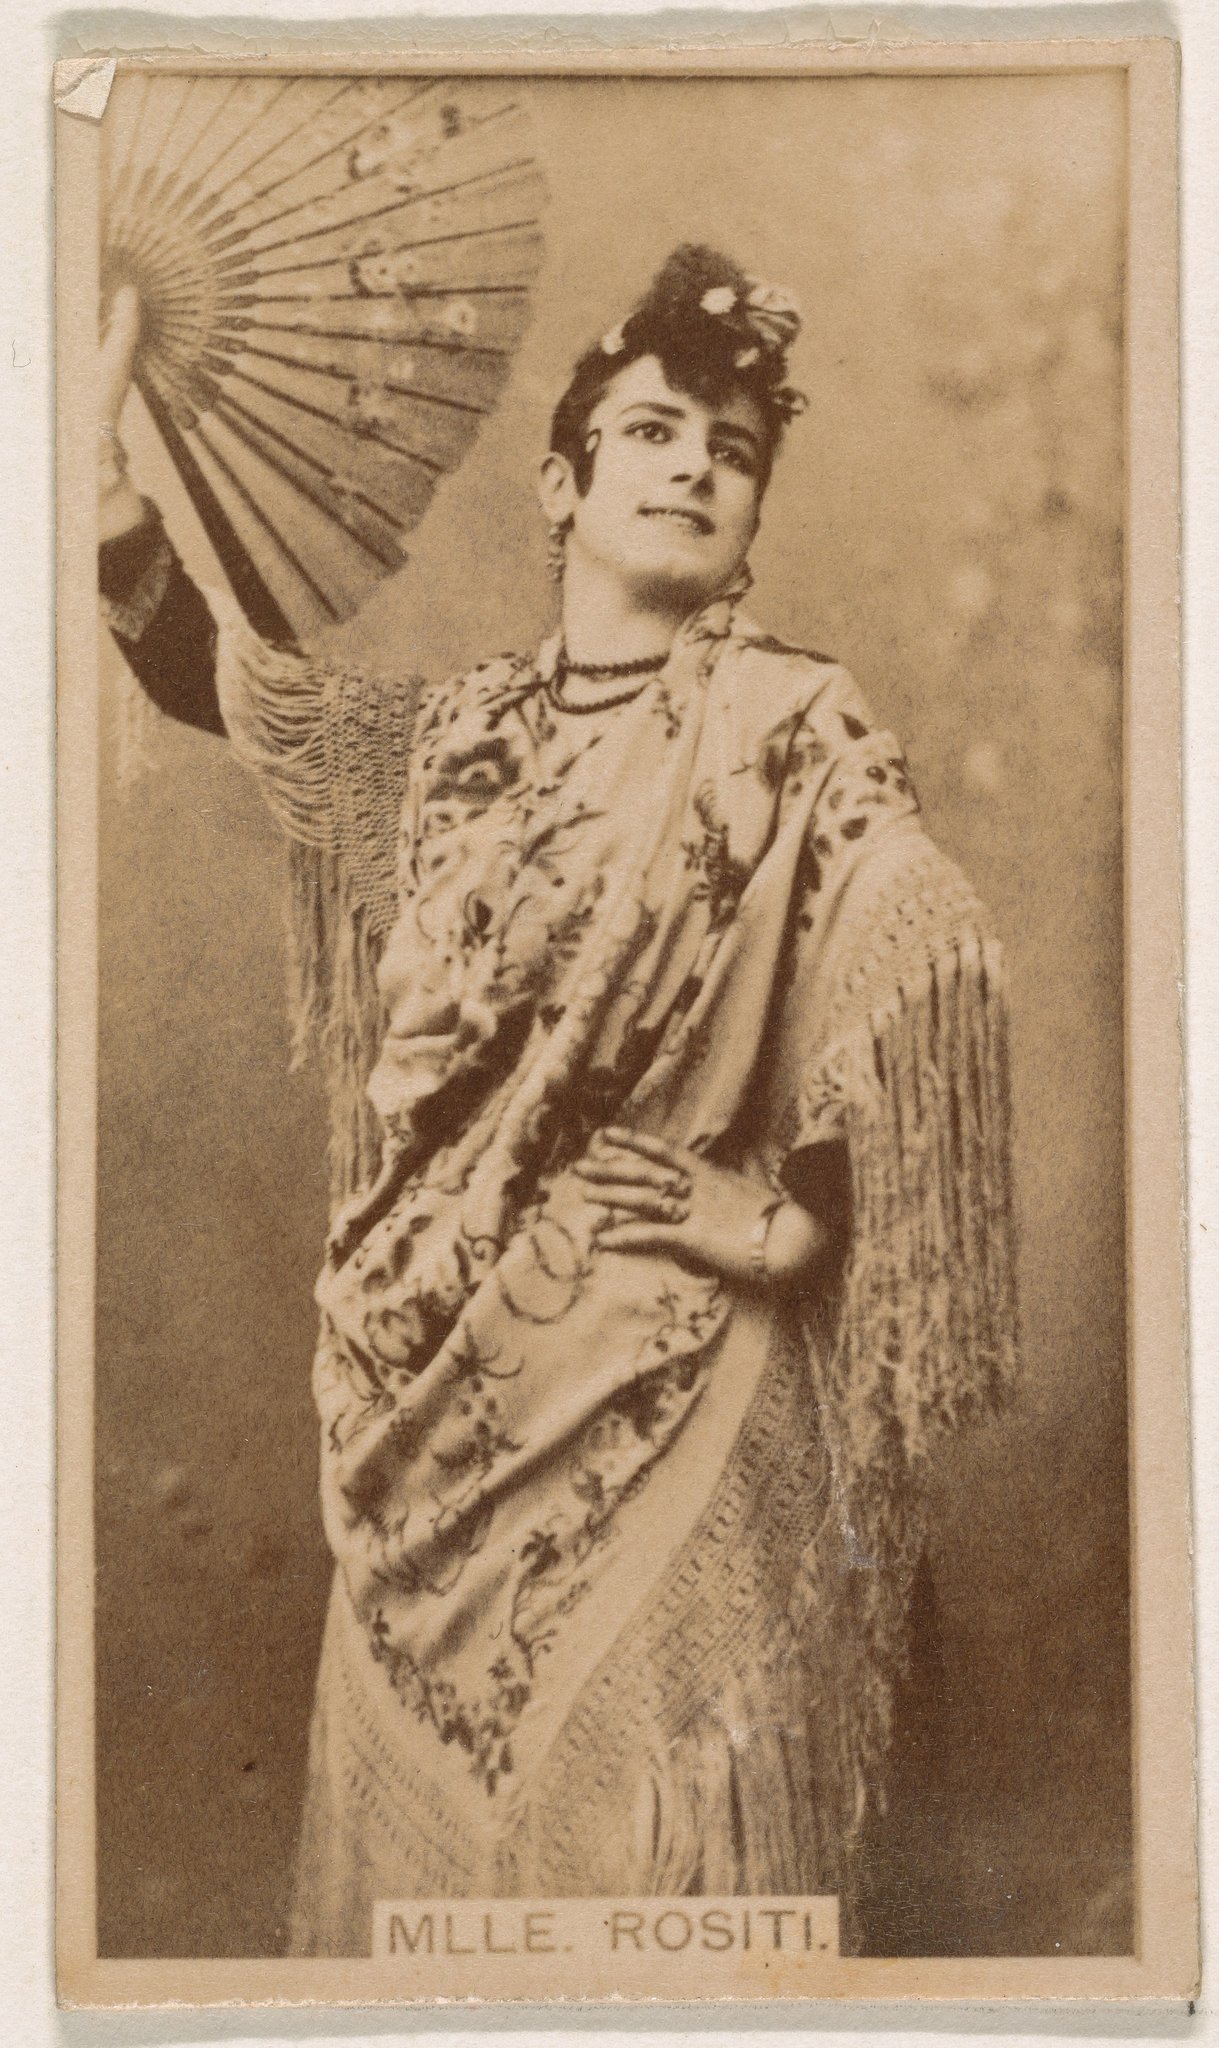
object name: photograph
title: Mlle. Rositi, from the Actresses series (N245) issued by Kinney Brothers to promote Sweet Caporal Cigarettes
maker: kinney brothers tobacco company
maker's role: publisher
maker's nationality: american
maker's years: 1869-2011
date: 1890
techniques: albumen silver print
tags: fans,portraits,women,actresses